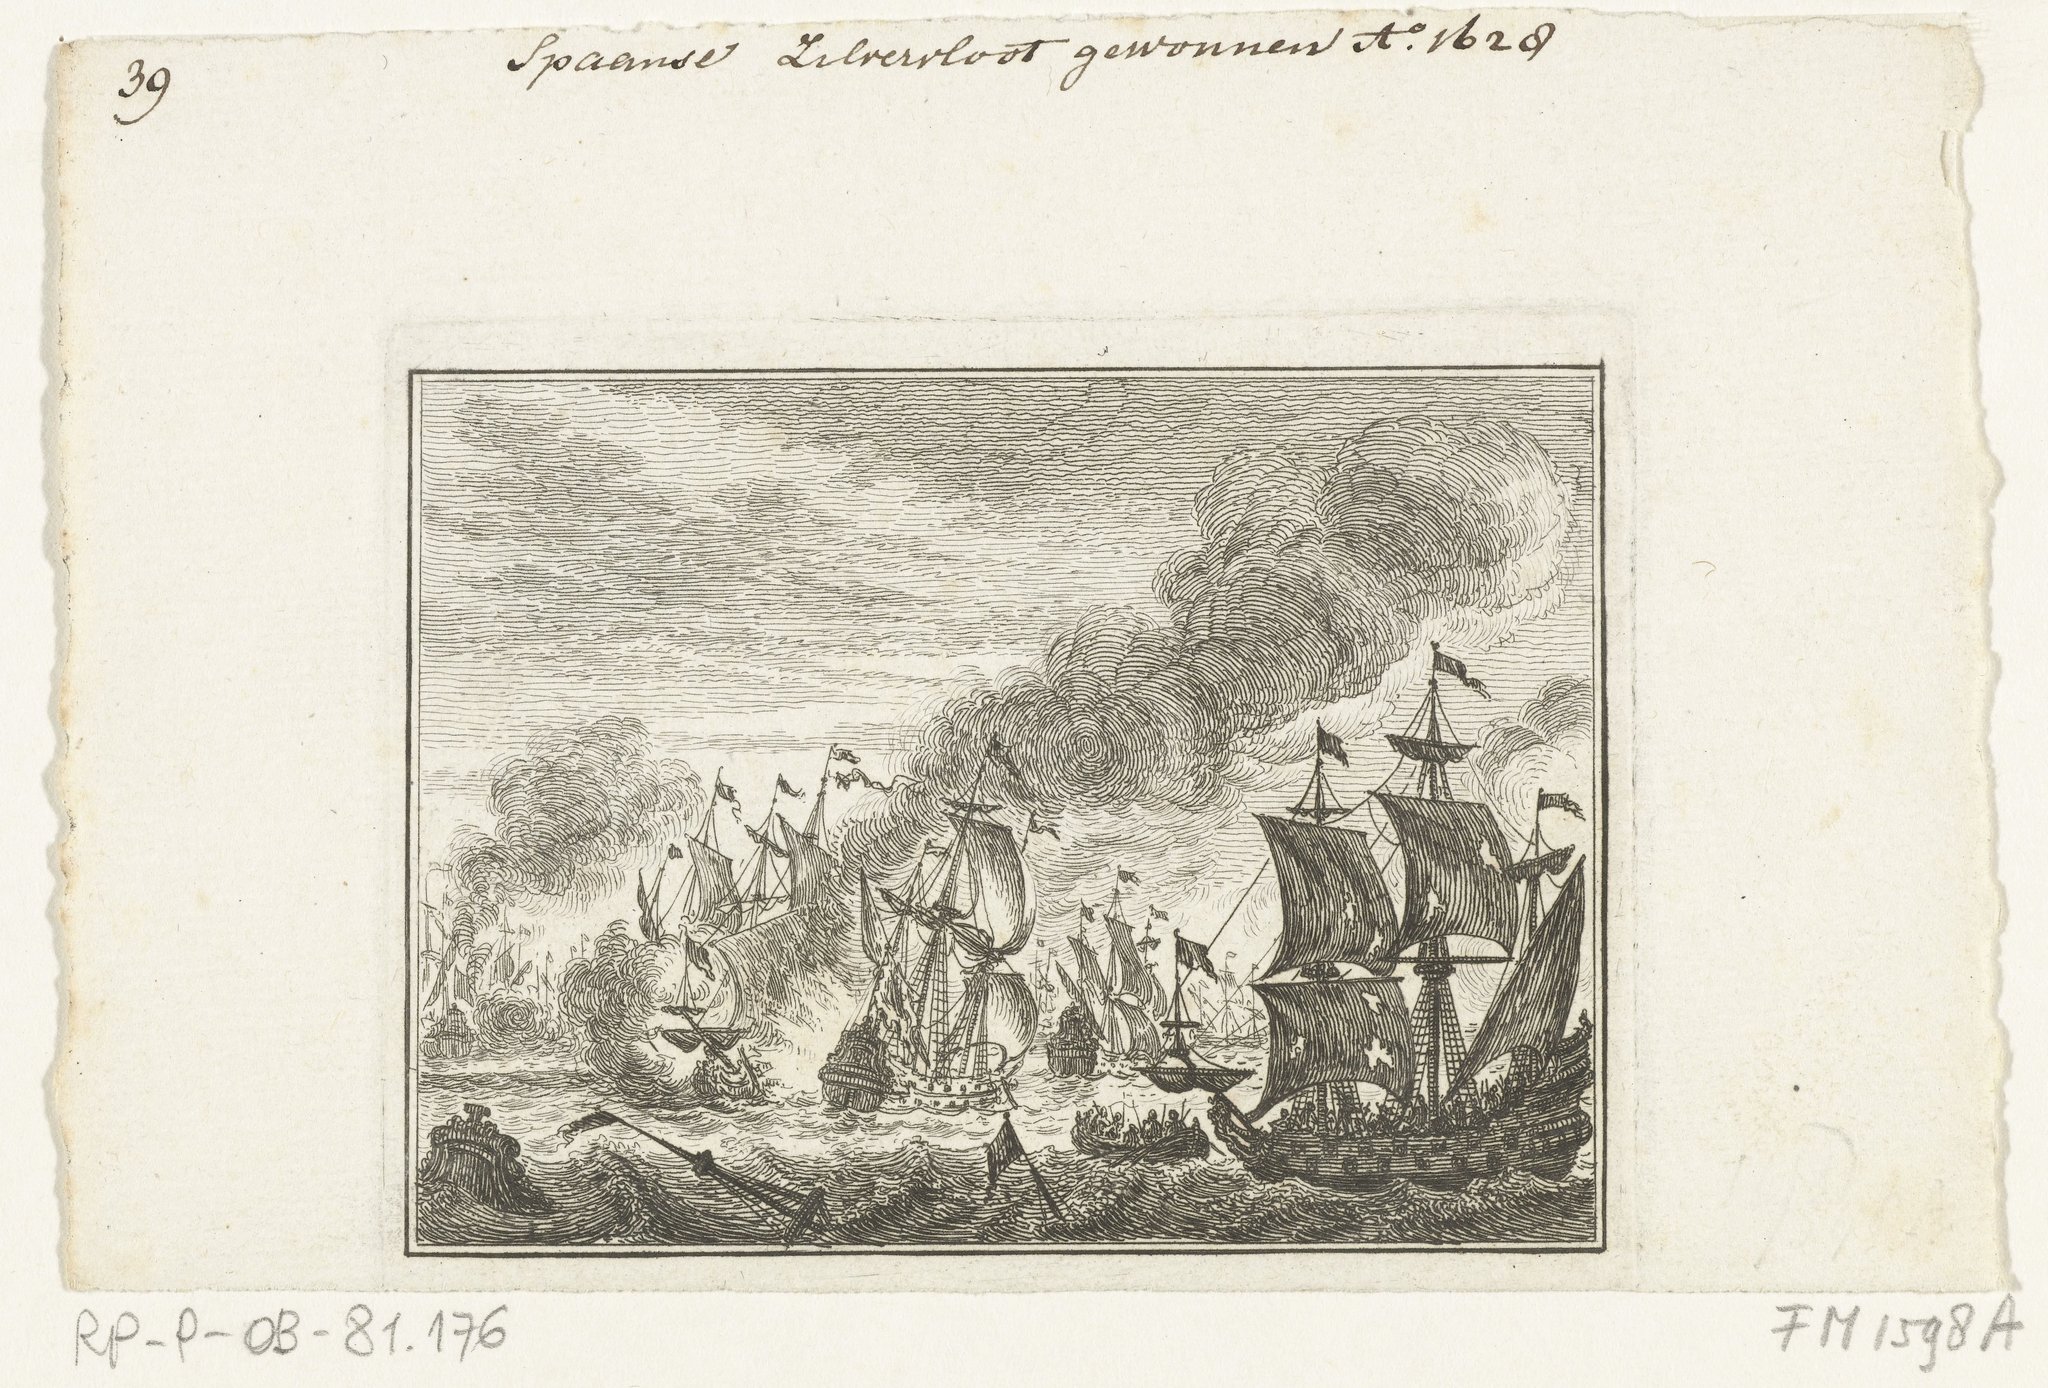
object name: print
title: Verovering van de Zilvervloot, 1628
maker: simon fokke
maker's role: draughtsman, print maker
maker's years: 1712-1784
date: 1782-1784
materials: paper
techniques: etching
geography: northern netherlands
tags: delfshaven, battle (+ naval force), capture of the spanish treasure fleet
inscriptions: inscription: ‘Spaanse Zilvervloot gewonnen Ao. 1628’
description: Gebruikt als illustratie in: J.W. te Water, De vaderlandsche Historie van den heere J. Wagenaar, verkort, en met leerzaame aanmerkingen, ten dienste der Nederlandsche jeugd, 1784-1800, 4 delen. Niet in Frederik Muller; door het RPK toegevoegd nummer.